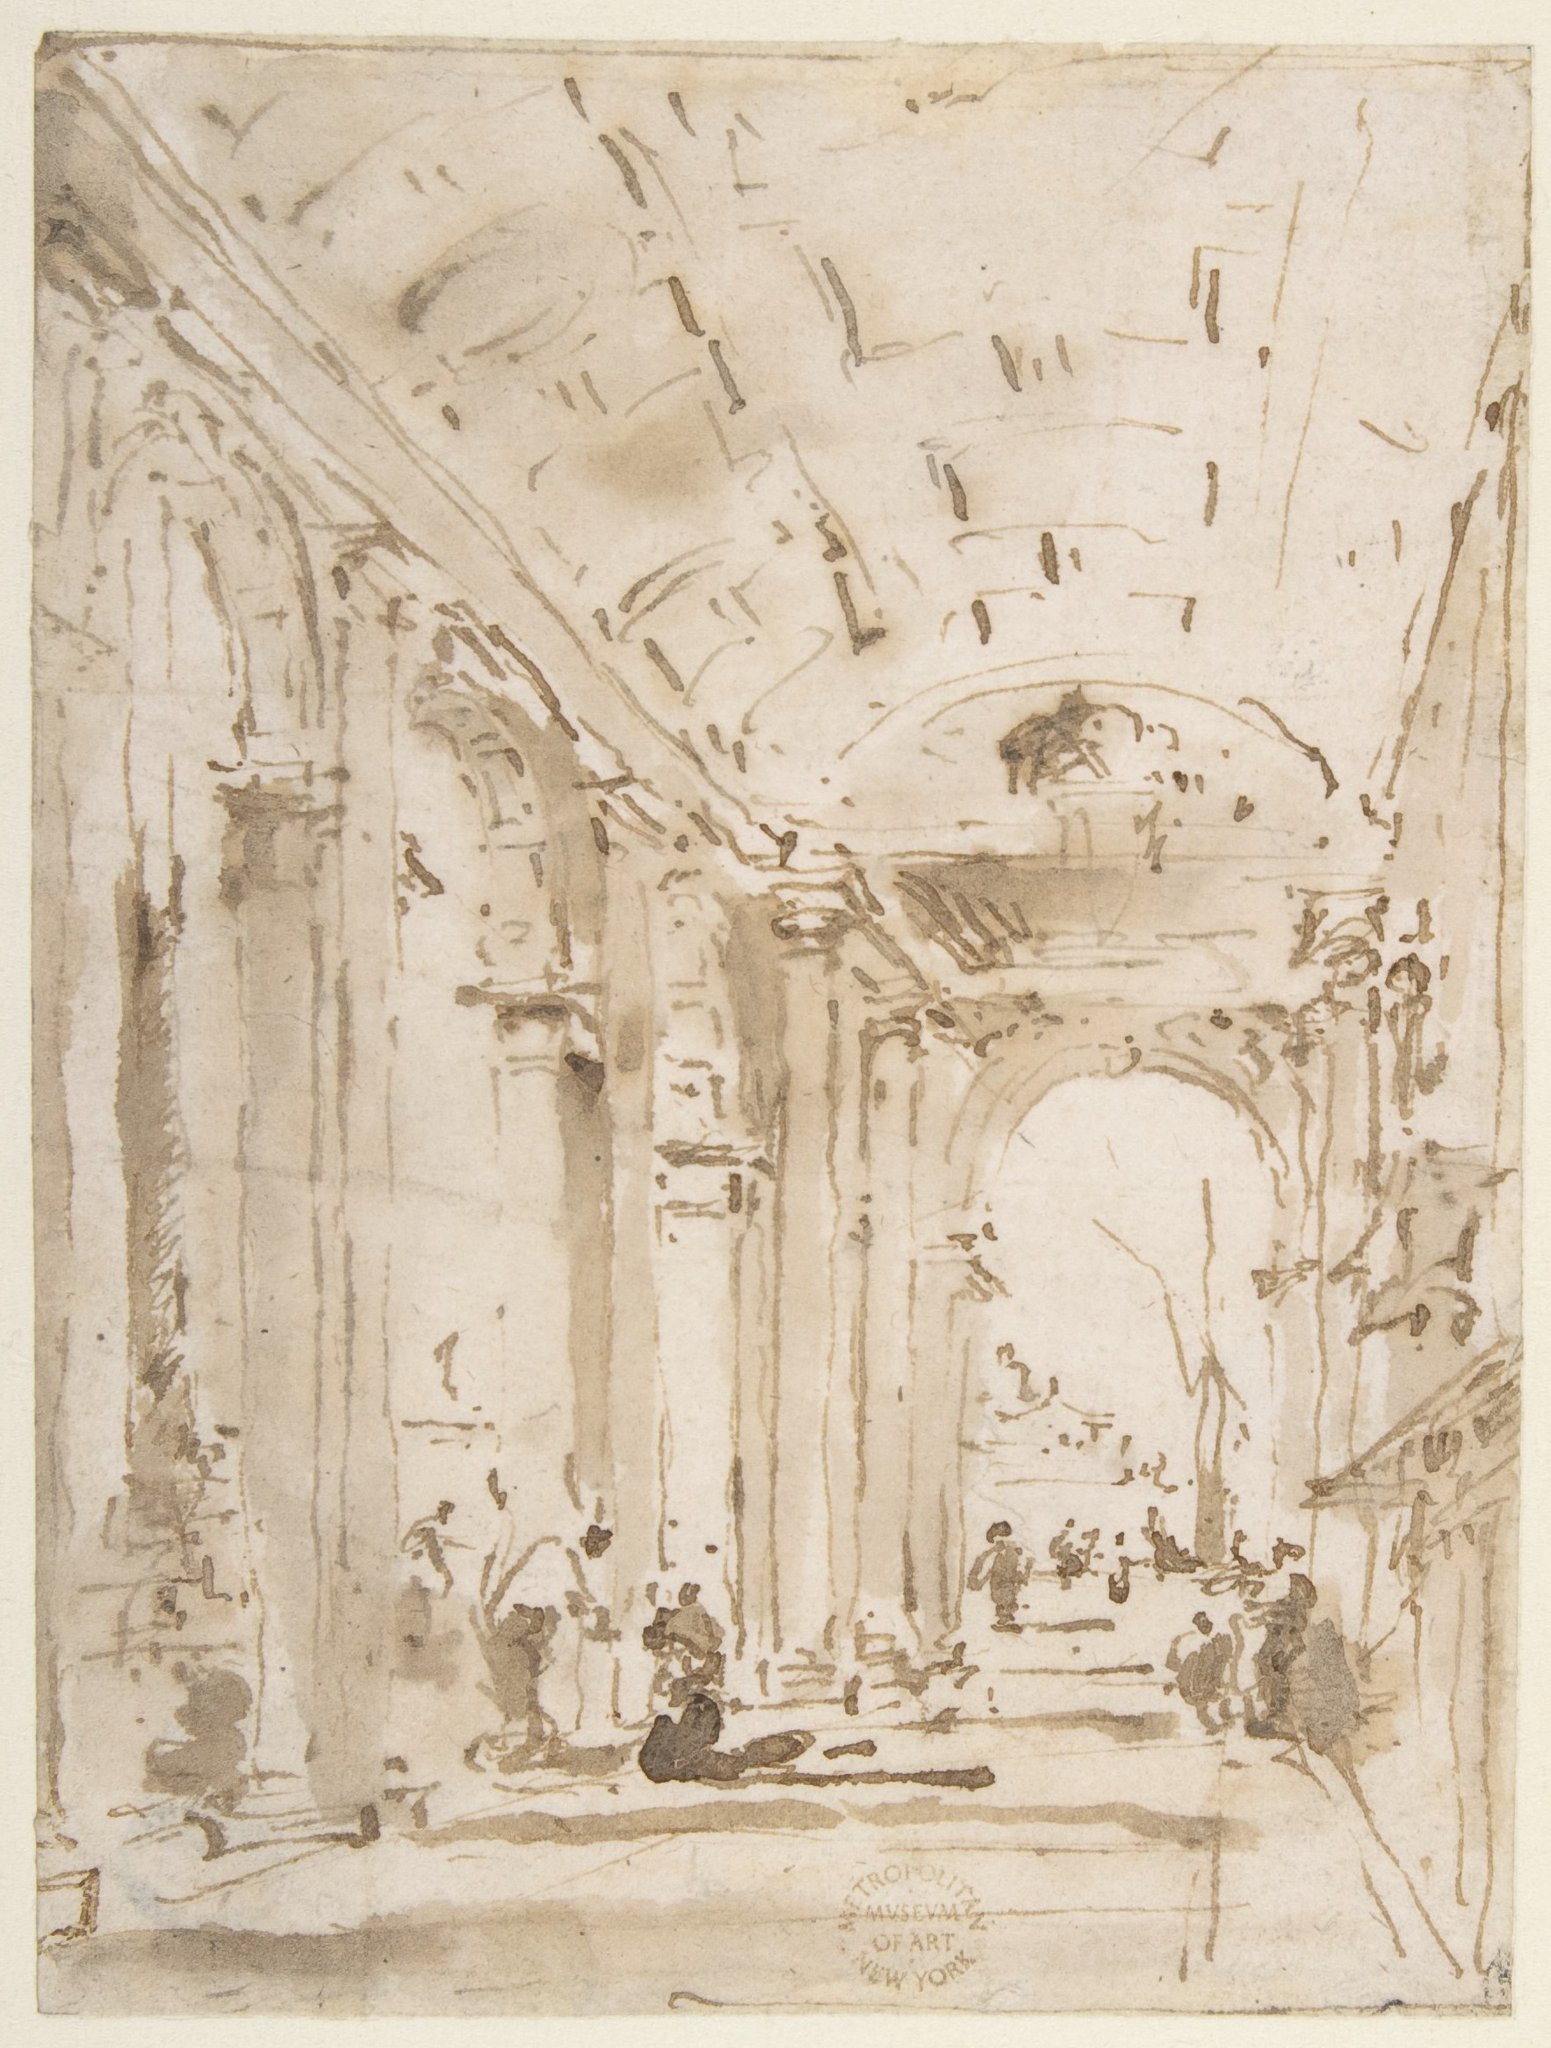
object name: drawing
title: The Arcade of the Libreria, Looking Toward San Giorgio Maggiore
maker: francesco guardi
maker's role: artist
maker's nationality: italian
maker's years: 1712-1793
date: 1712-1793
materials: ink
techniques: brush, pen, wash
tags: arches